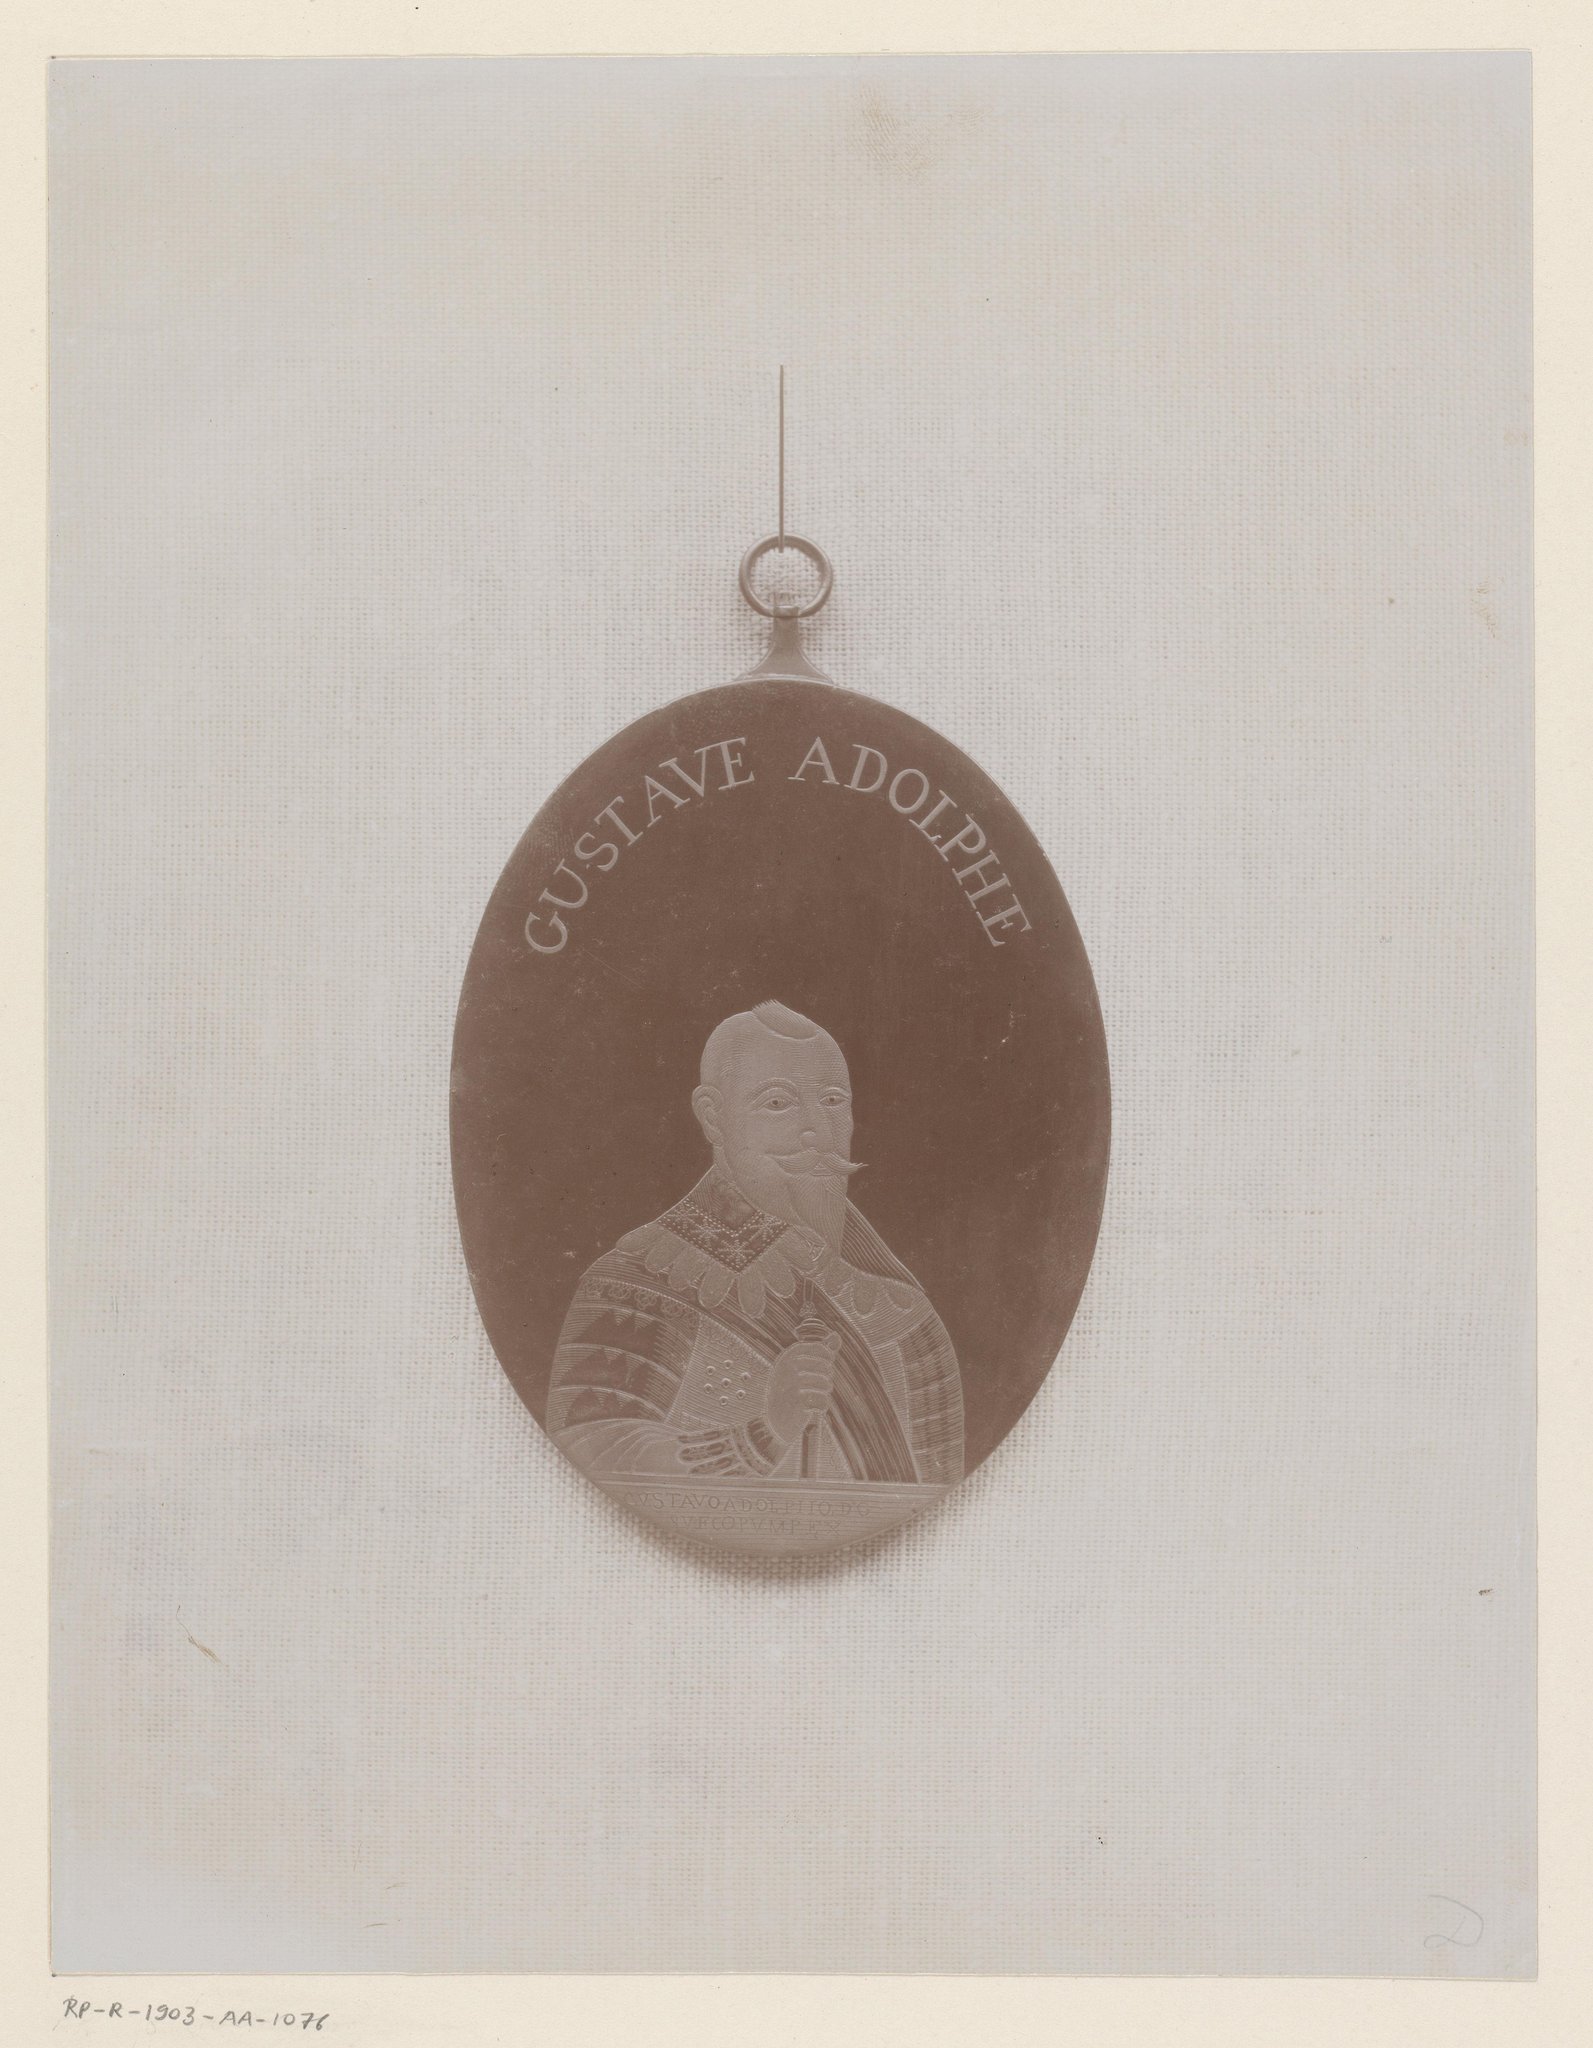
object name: reproduction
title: Fotoreproductie van een portret van Gustaaf II Adolf, koning van Zweden, op een plaquette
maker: cornelis johannes steenbergh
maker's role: fotograaf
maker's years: 1859-1939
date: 1903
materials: paper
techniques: collodion silver print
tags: historical persons, king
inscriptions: inscription: ‘D’, inscription: ‘Gefotografeerd/ door/ C.J. Steenbergh./ D’, collector's mark: Lugt 2228